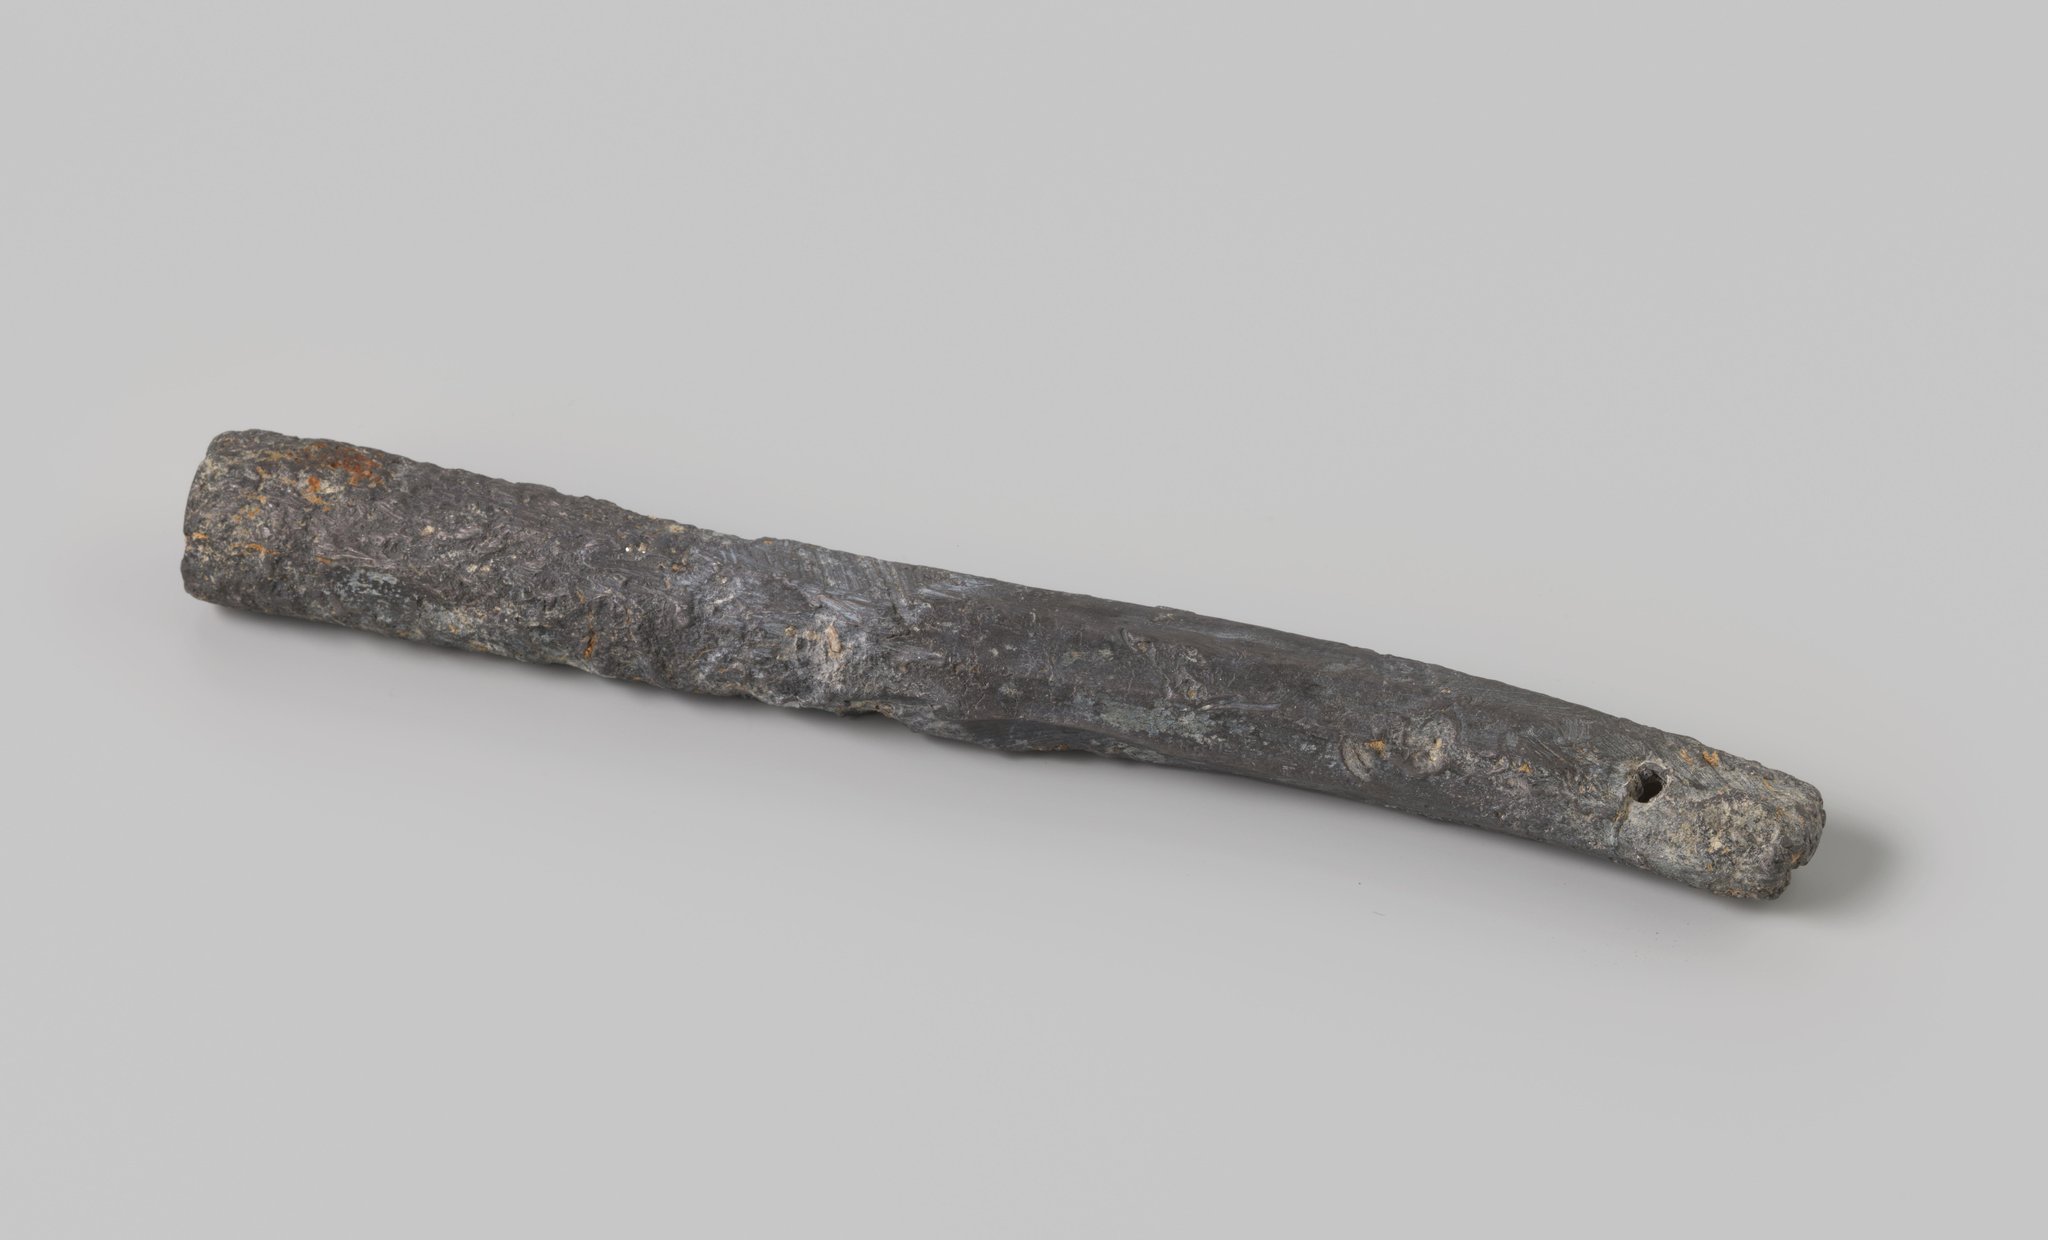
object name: sounding lead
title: Dieplood uit het wrak van de Oost-Indiëvaarder Hollandia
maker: Anonymous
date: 1700-1743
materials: lead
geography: netherlands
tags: verenigde oostindische compagnie, hollandia (schip), annet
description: Tools and instruments, navigation, sounding lead; octagonal faceted, tapering upwards, flat pierced upper end, domed cavity in underside, bent.